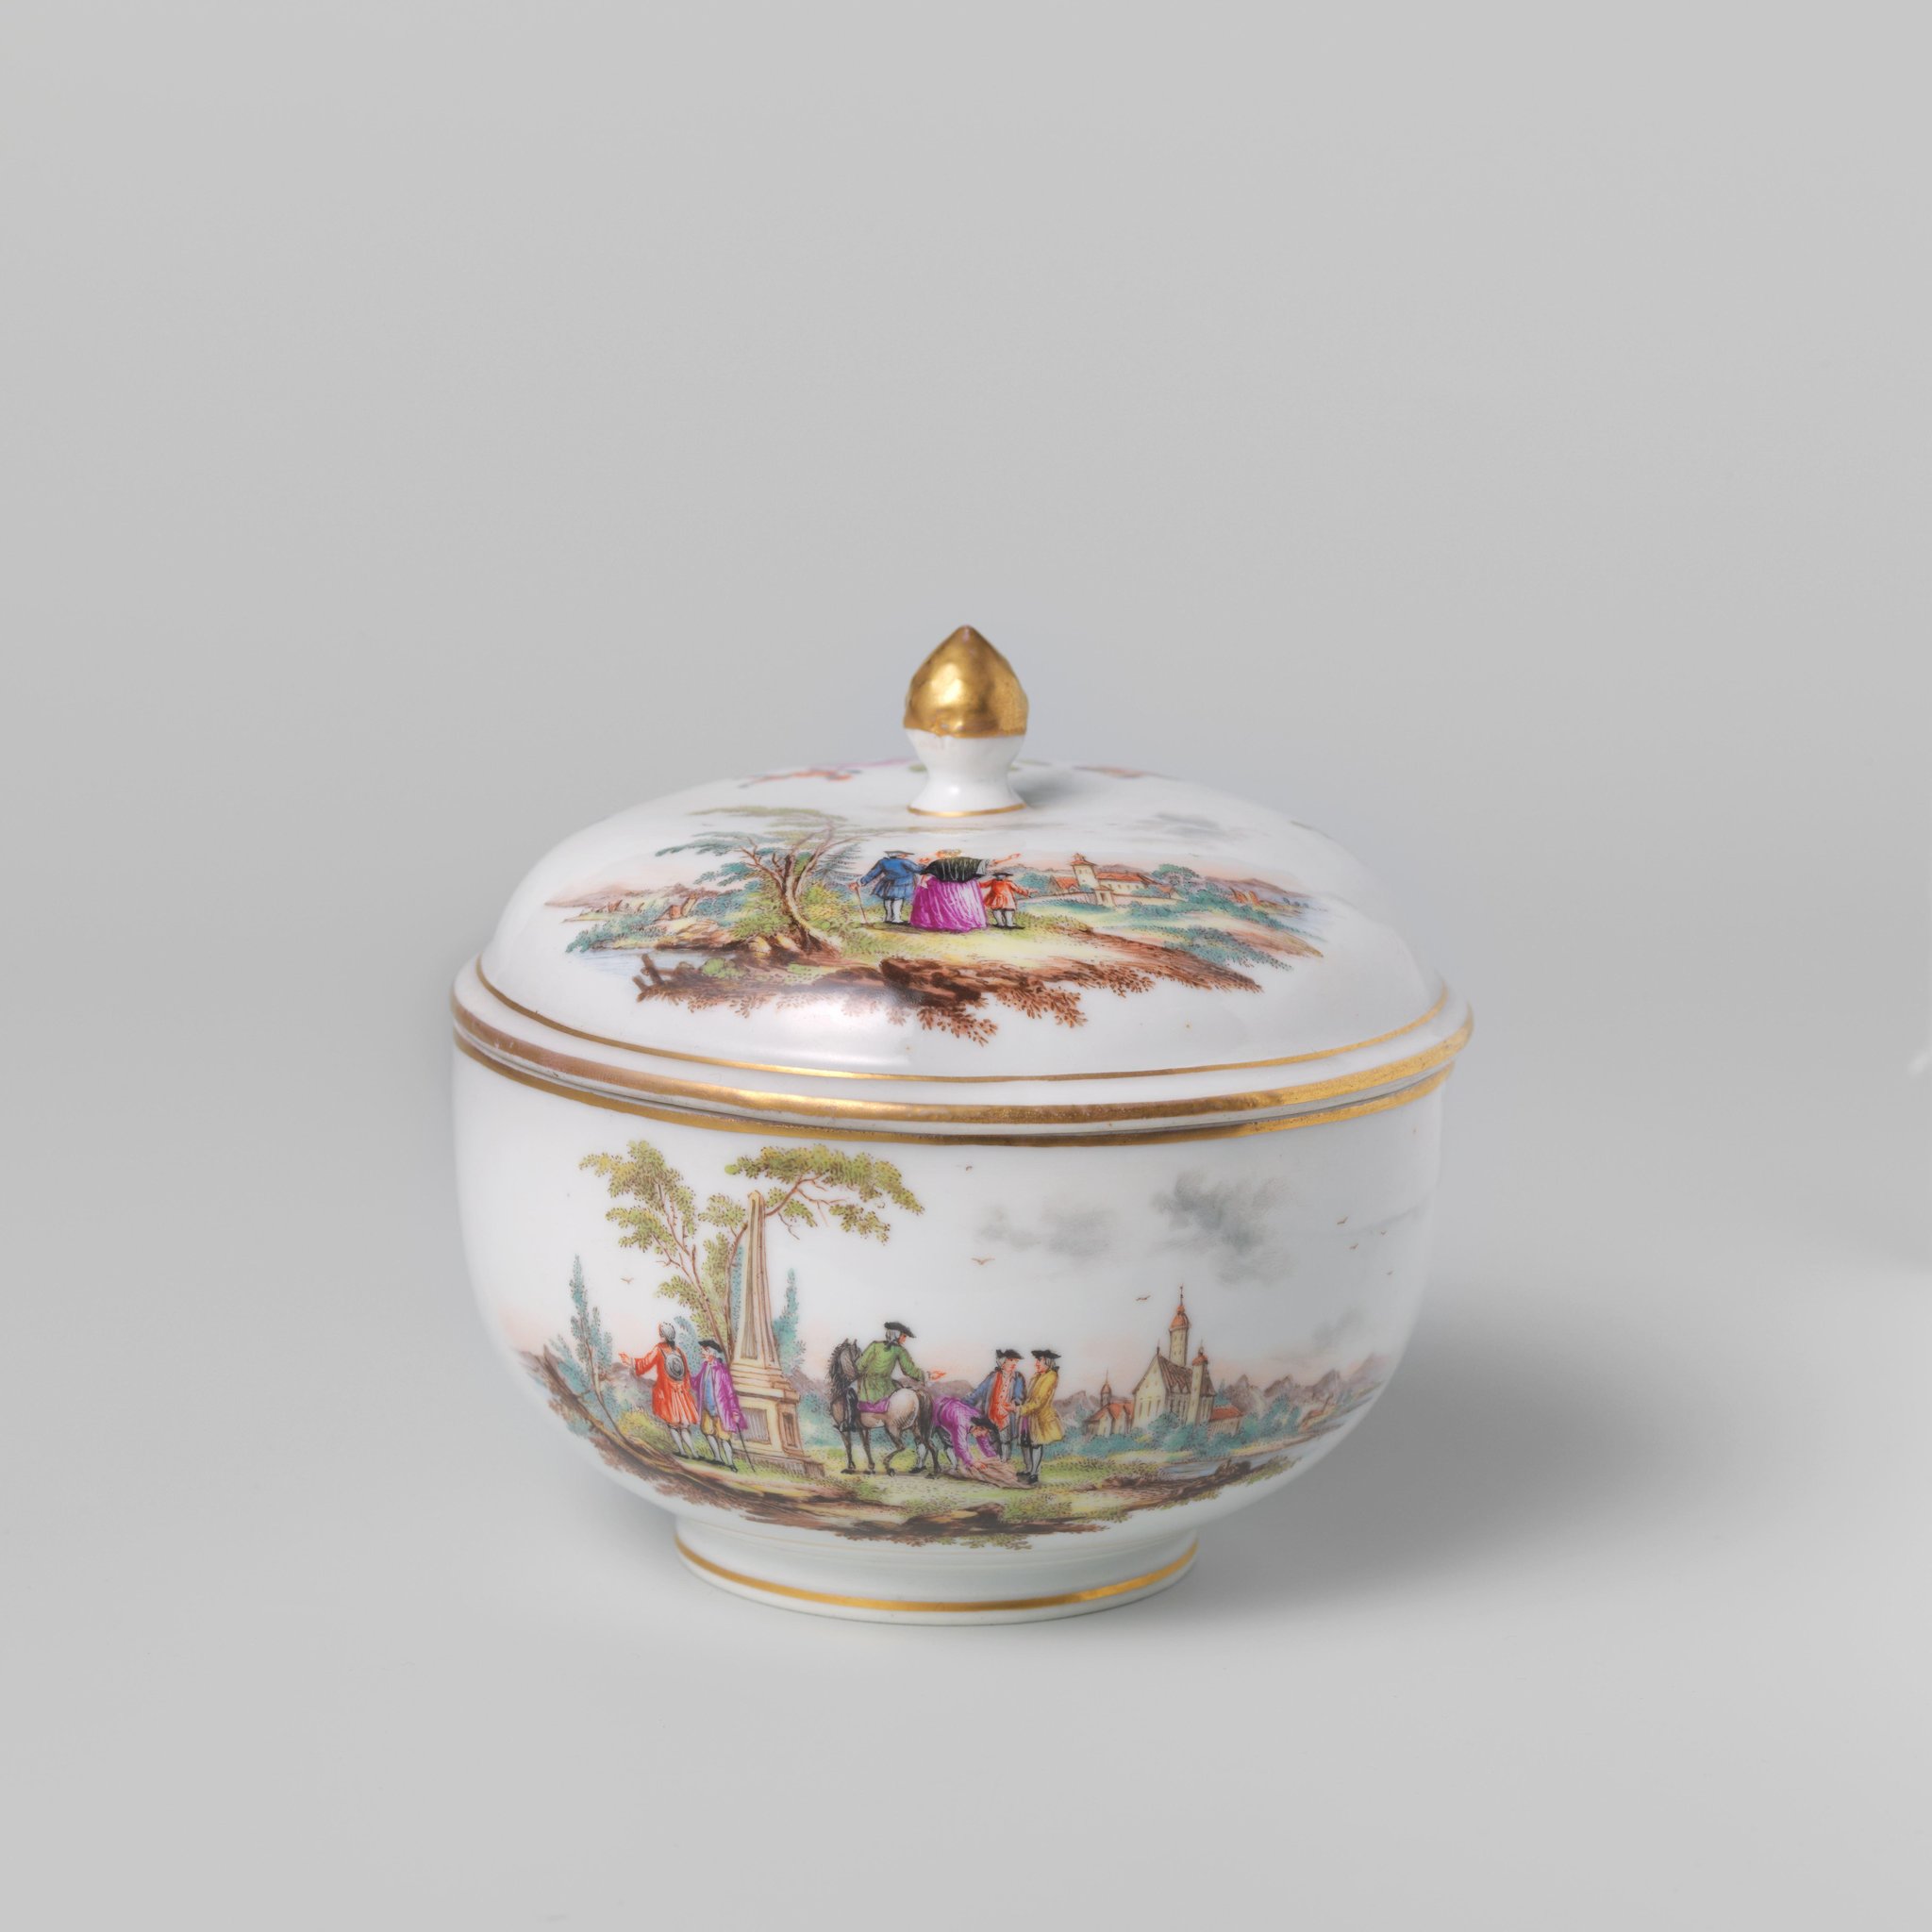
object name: tea service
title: Cover of a sugar bowl with a landscape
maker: Anonymous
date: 1765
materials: glaze, gold, paint, porcelain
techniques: firing, forming, gilding, vitrification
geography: sint-petersburg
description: Deksel van een suikerpot van porselein, beschilderd op het glazuur in emailkleuren en goud. Versierd met een landschap en een boeket; puntige dekselknop. Gouden rand. Mogelijk een 19e of 20e eeuwse vervalsing.